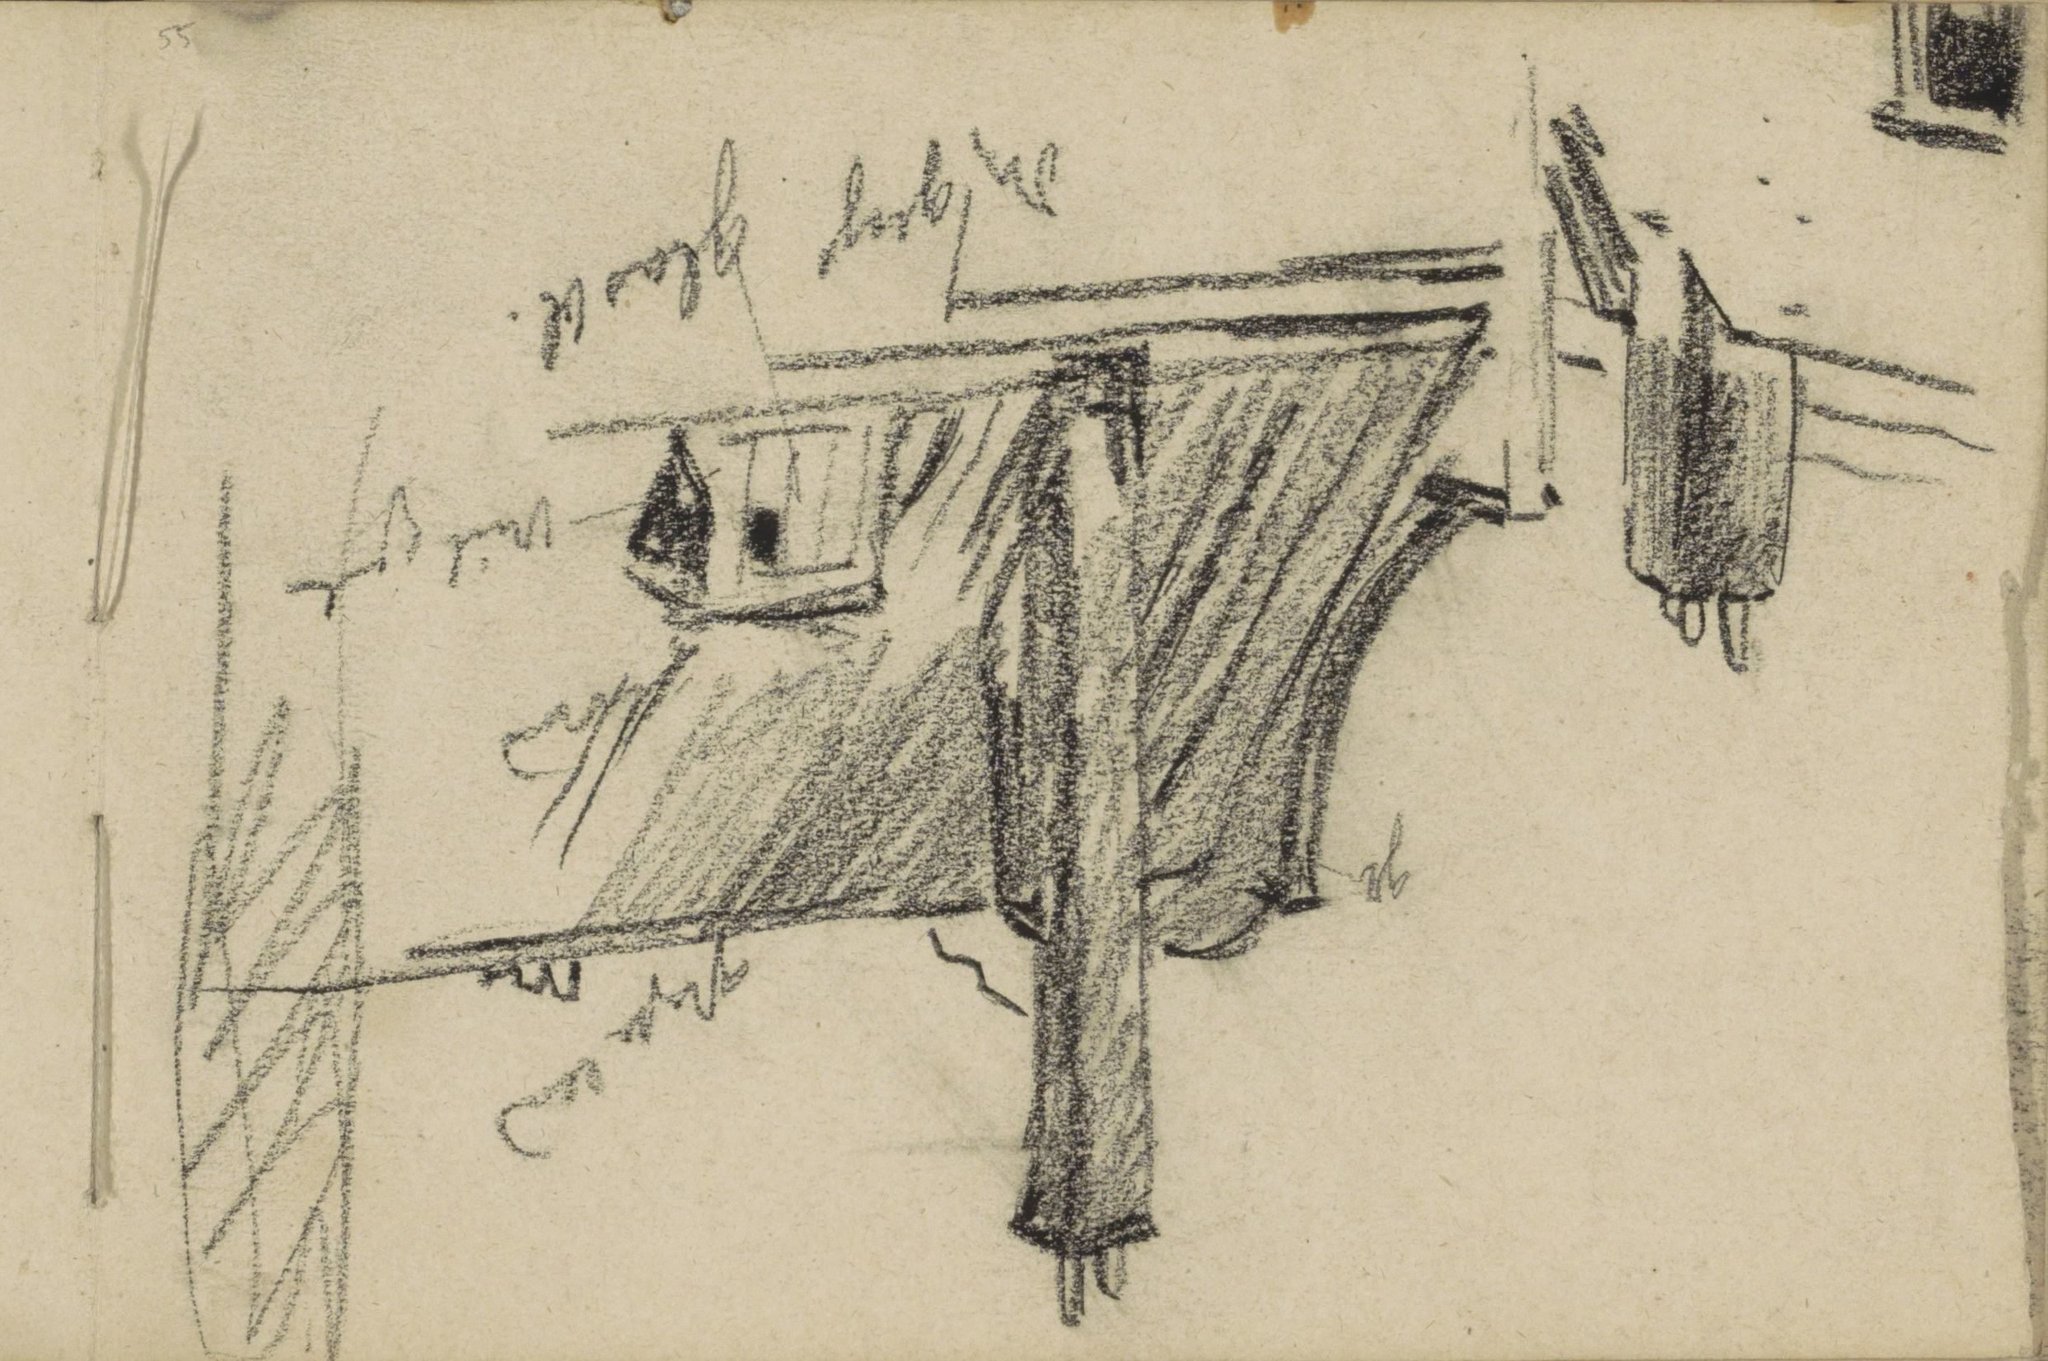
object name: sketchbook leaf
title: Dak van het pand Korte Dijkstraat 2 in Amsterdam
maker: willem witsen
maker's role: draughtsman, painter, print maker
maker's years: 1860-1923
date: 1907-1909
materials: chalk, paper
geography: amsterdam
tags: chimney, roof (of house or building)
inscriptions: : ‘[...]’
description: Witsen begon met het vervaardigen van de prenten in september 1907.